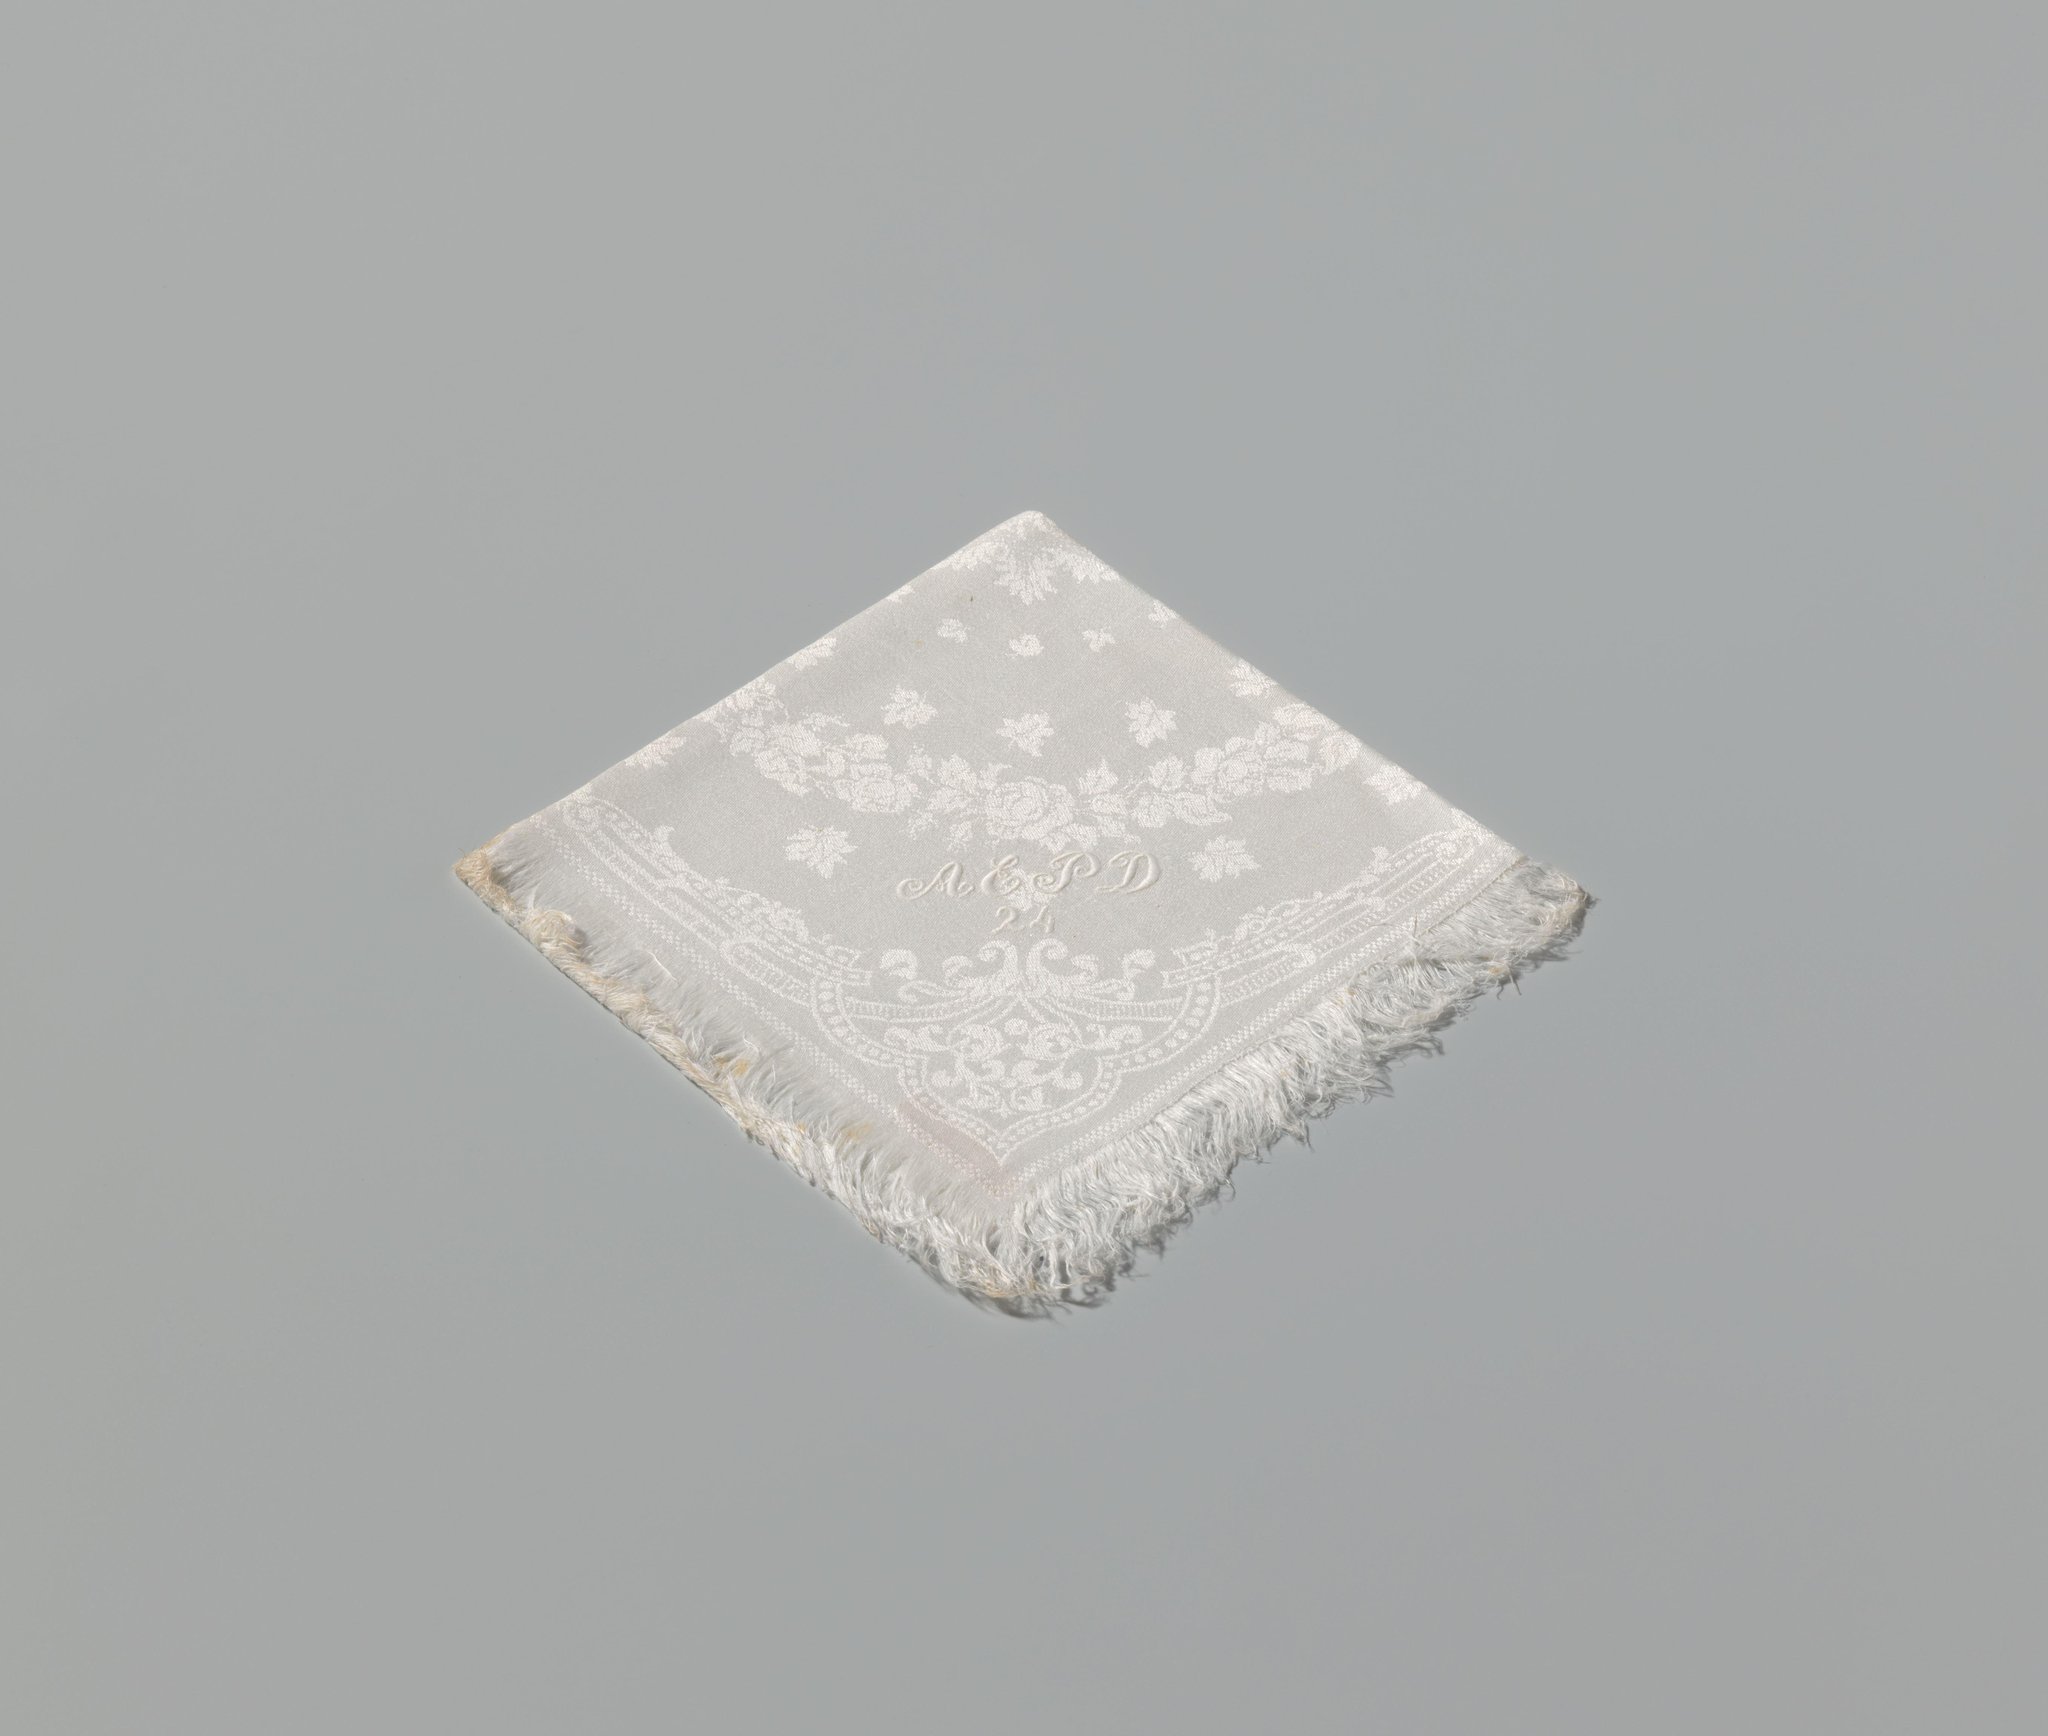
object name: vingerdoek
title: Vingerdoek van linnendamast met een bloempatroon.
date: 1875-1900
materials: linen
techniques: damask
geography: netherlands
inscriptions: monogram: ‘AEPD 24’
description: Vingerdoek van linnendamast met op het veld een bloemenkrans waarbinnen een rozet van bladeren en waaromheen gestrooide bladeren. Langs de rand een bloempatroon. De vingerdoek heeft franje langs de rand en in wit geborduurde letters AEPD24. De vingerdoek hoort bij negen vingerdoeken (BK-1979-269-A t/m BK-1979-269-J).